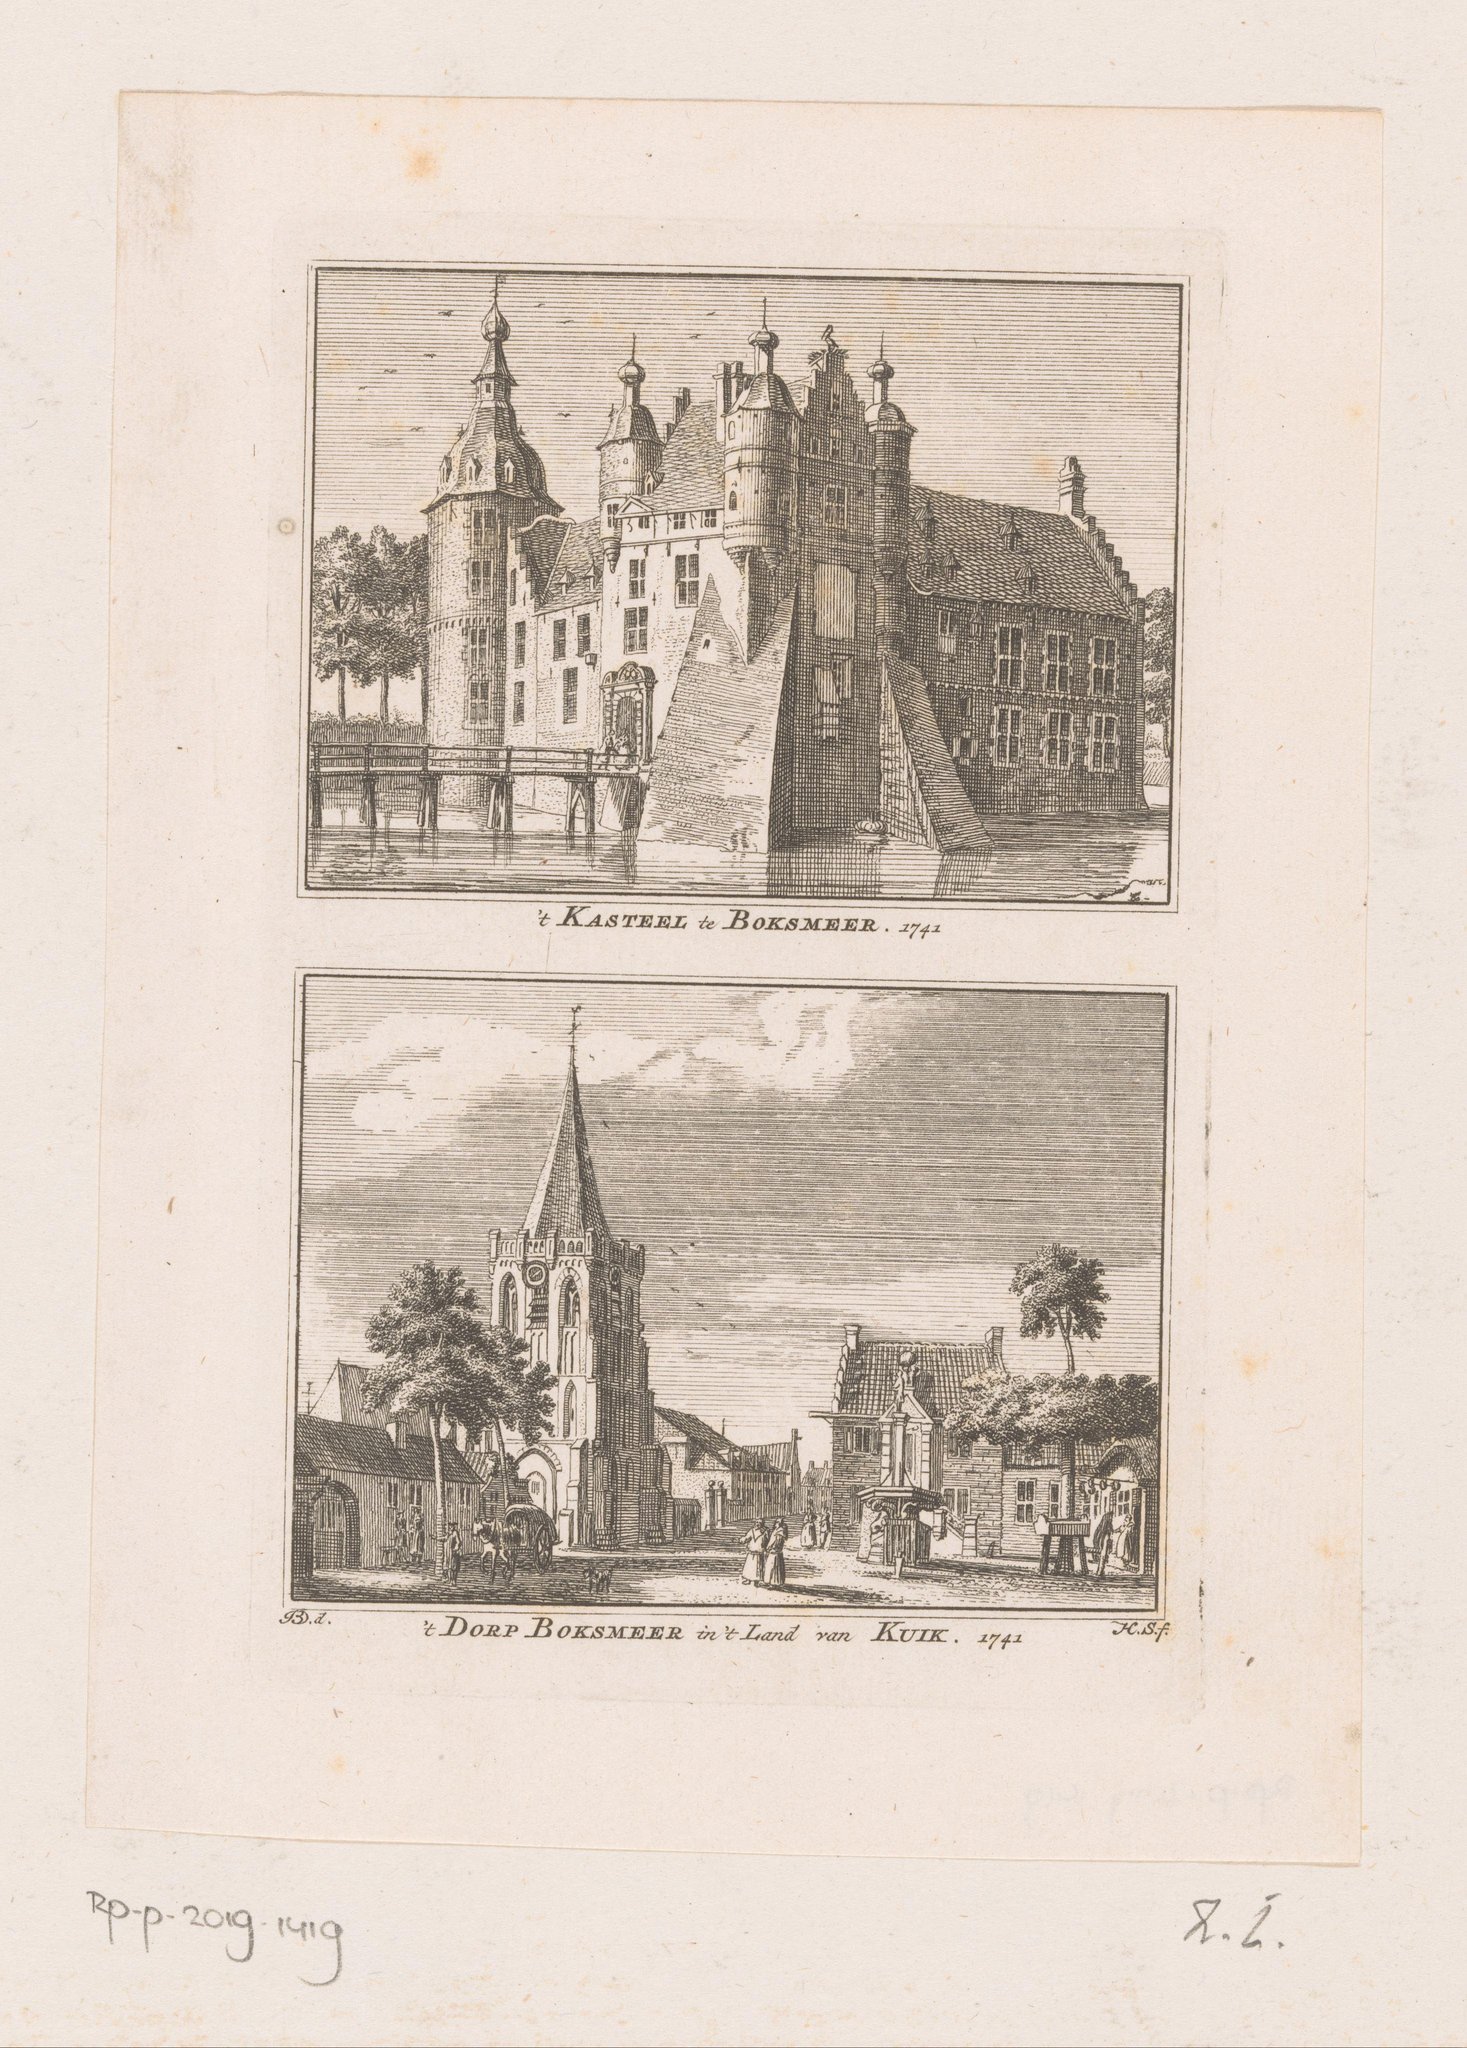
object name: print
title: 't Dorp Boksmeer in 't Land van Kuik, 1741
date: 1745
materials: paper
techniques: engraving, etching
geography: amsterdam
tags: prospect of village, silhouette of village, castle, church (exterior), boxmeer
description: Prent uit: Spilman, Hendrik. Het verheerlykt Nederland, of kabinet van hedendaagsche gezigten. 9 dln. Amsterdam: Isaac Tirion, 1745-1774, dl. 1 (1745).